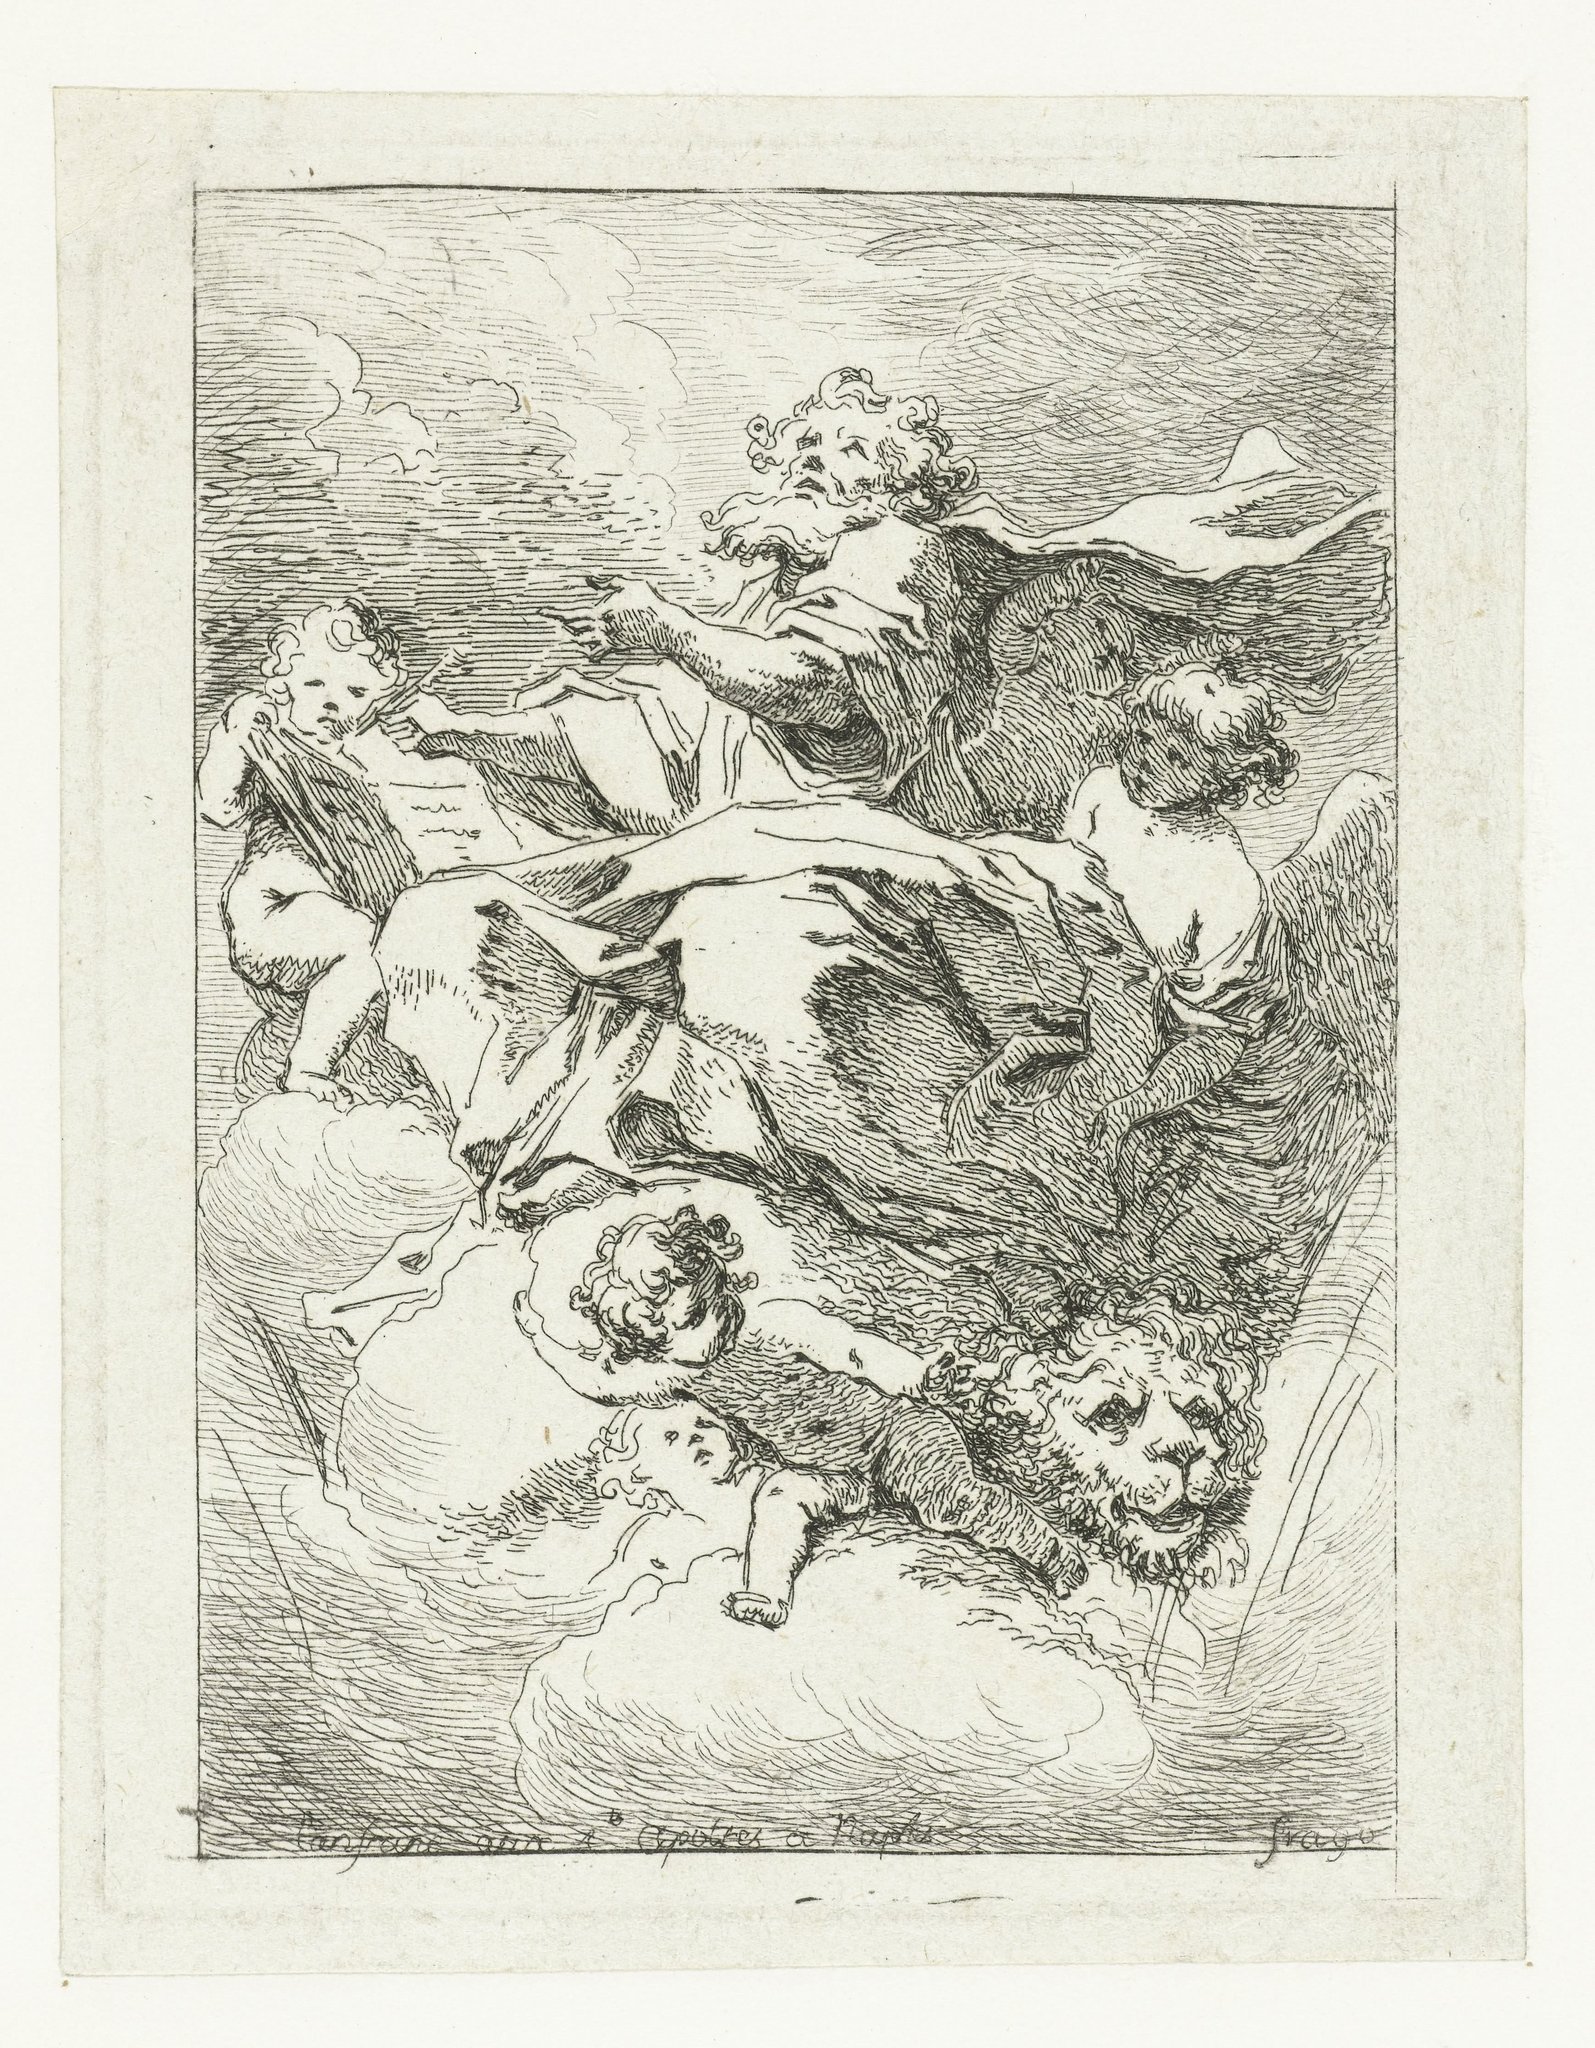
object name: print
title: Evangelist Marcus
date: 1763-1764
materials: paper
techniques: etching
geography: italy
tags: st. mark the evangelist writing the gospel, usually a (winged) lion present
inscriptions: collector's mark: Lugt 2760, collector's mark: Lugt 2228, inscription: ‘Lanfranc aux Sts Apôstre à Naples’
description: De evangelist Marcus op een wolk, omringd door drie putti en een leeuw. Eén putto houdt het boek vast.